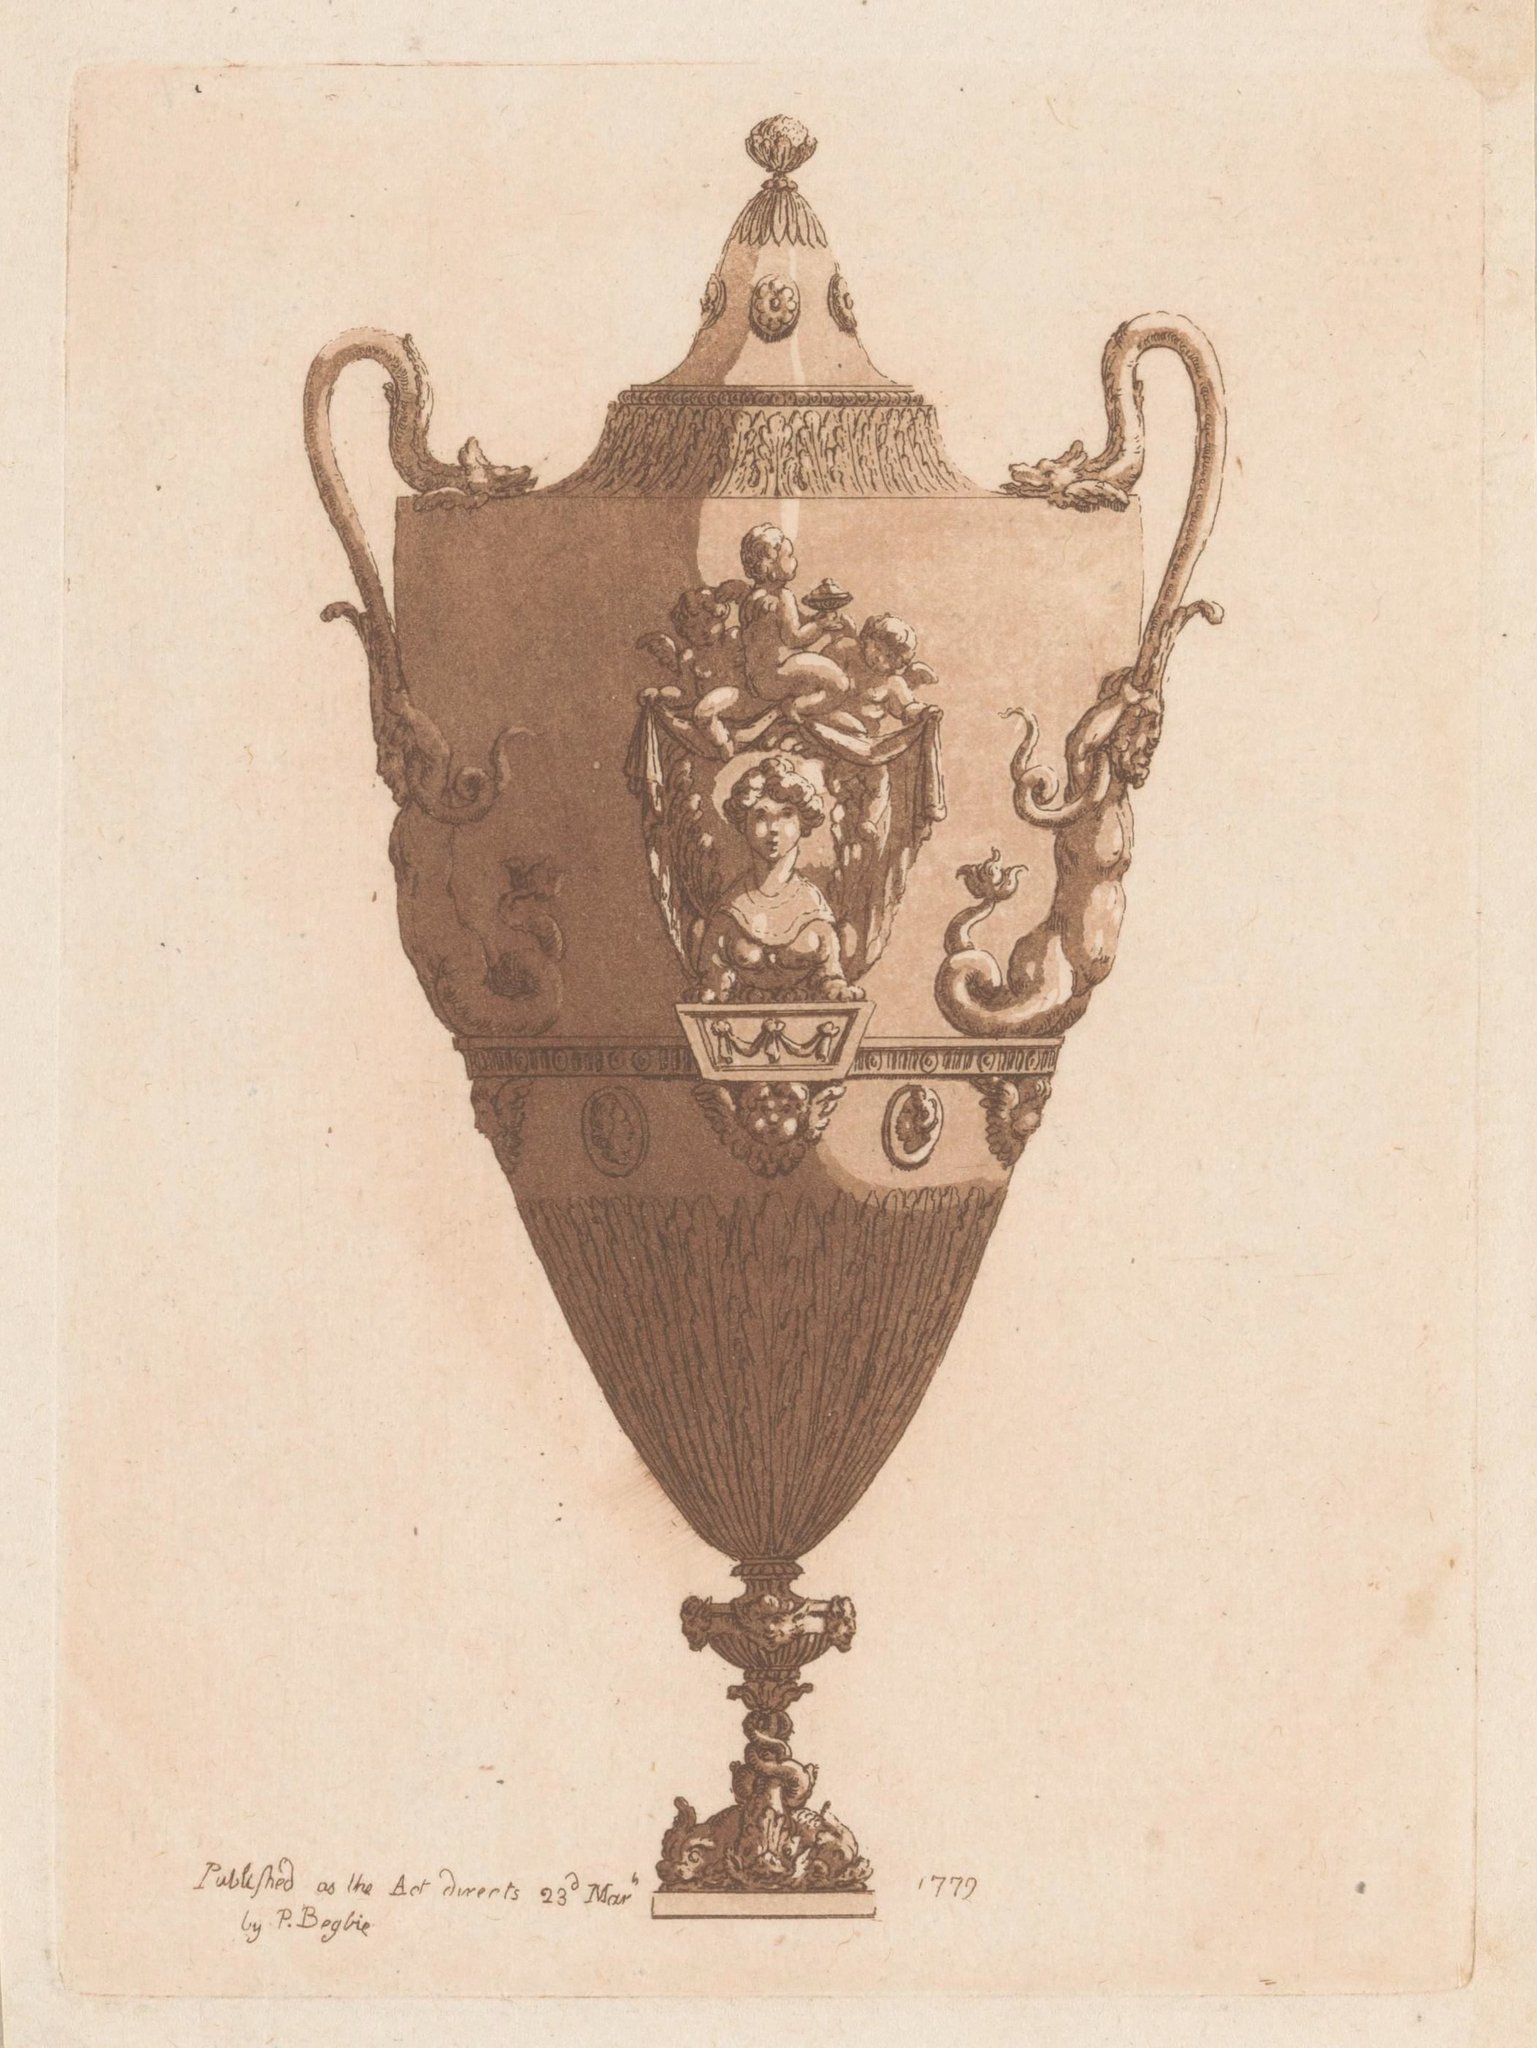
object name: print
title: Vases after the manner of the Antique (...)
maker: patrick begbie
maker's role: print maker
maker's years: -1820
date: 1779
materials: paper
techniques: aquatint, etching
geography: london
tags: sphinx (lion/woman); 'sfinge' (ripa), vase ~ ornament, cupids: 'amores', 'amoretti', 'putti'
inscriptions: collector's mark: Lugt 2228, collector's mark: Lugt 2760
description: Een antieke geornamenteerde vaas met een sfinx van de voorzijde gezien waarboven drie putti, links en rechts twee figuren en twee oren.